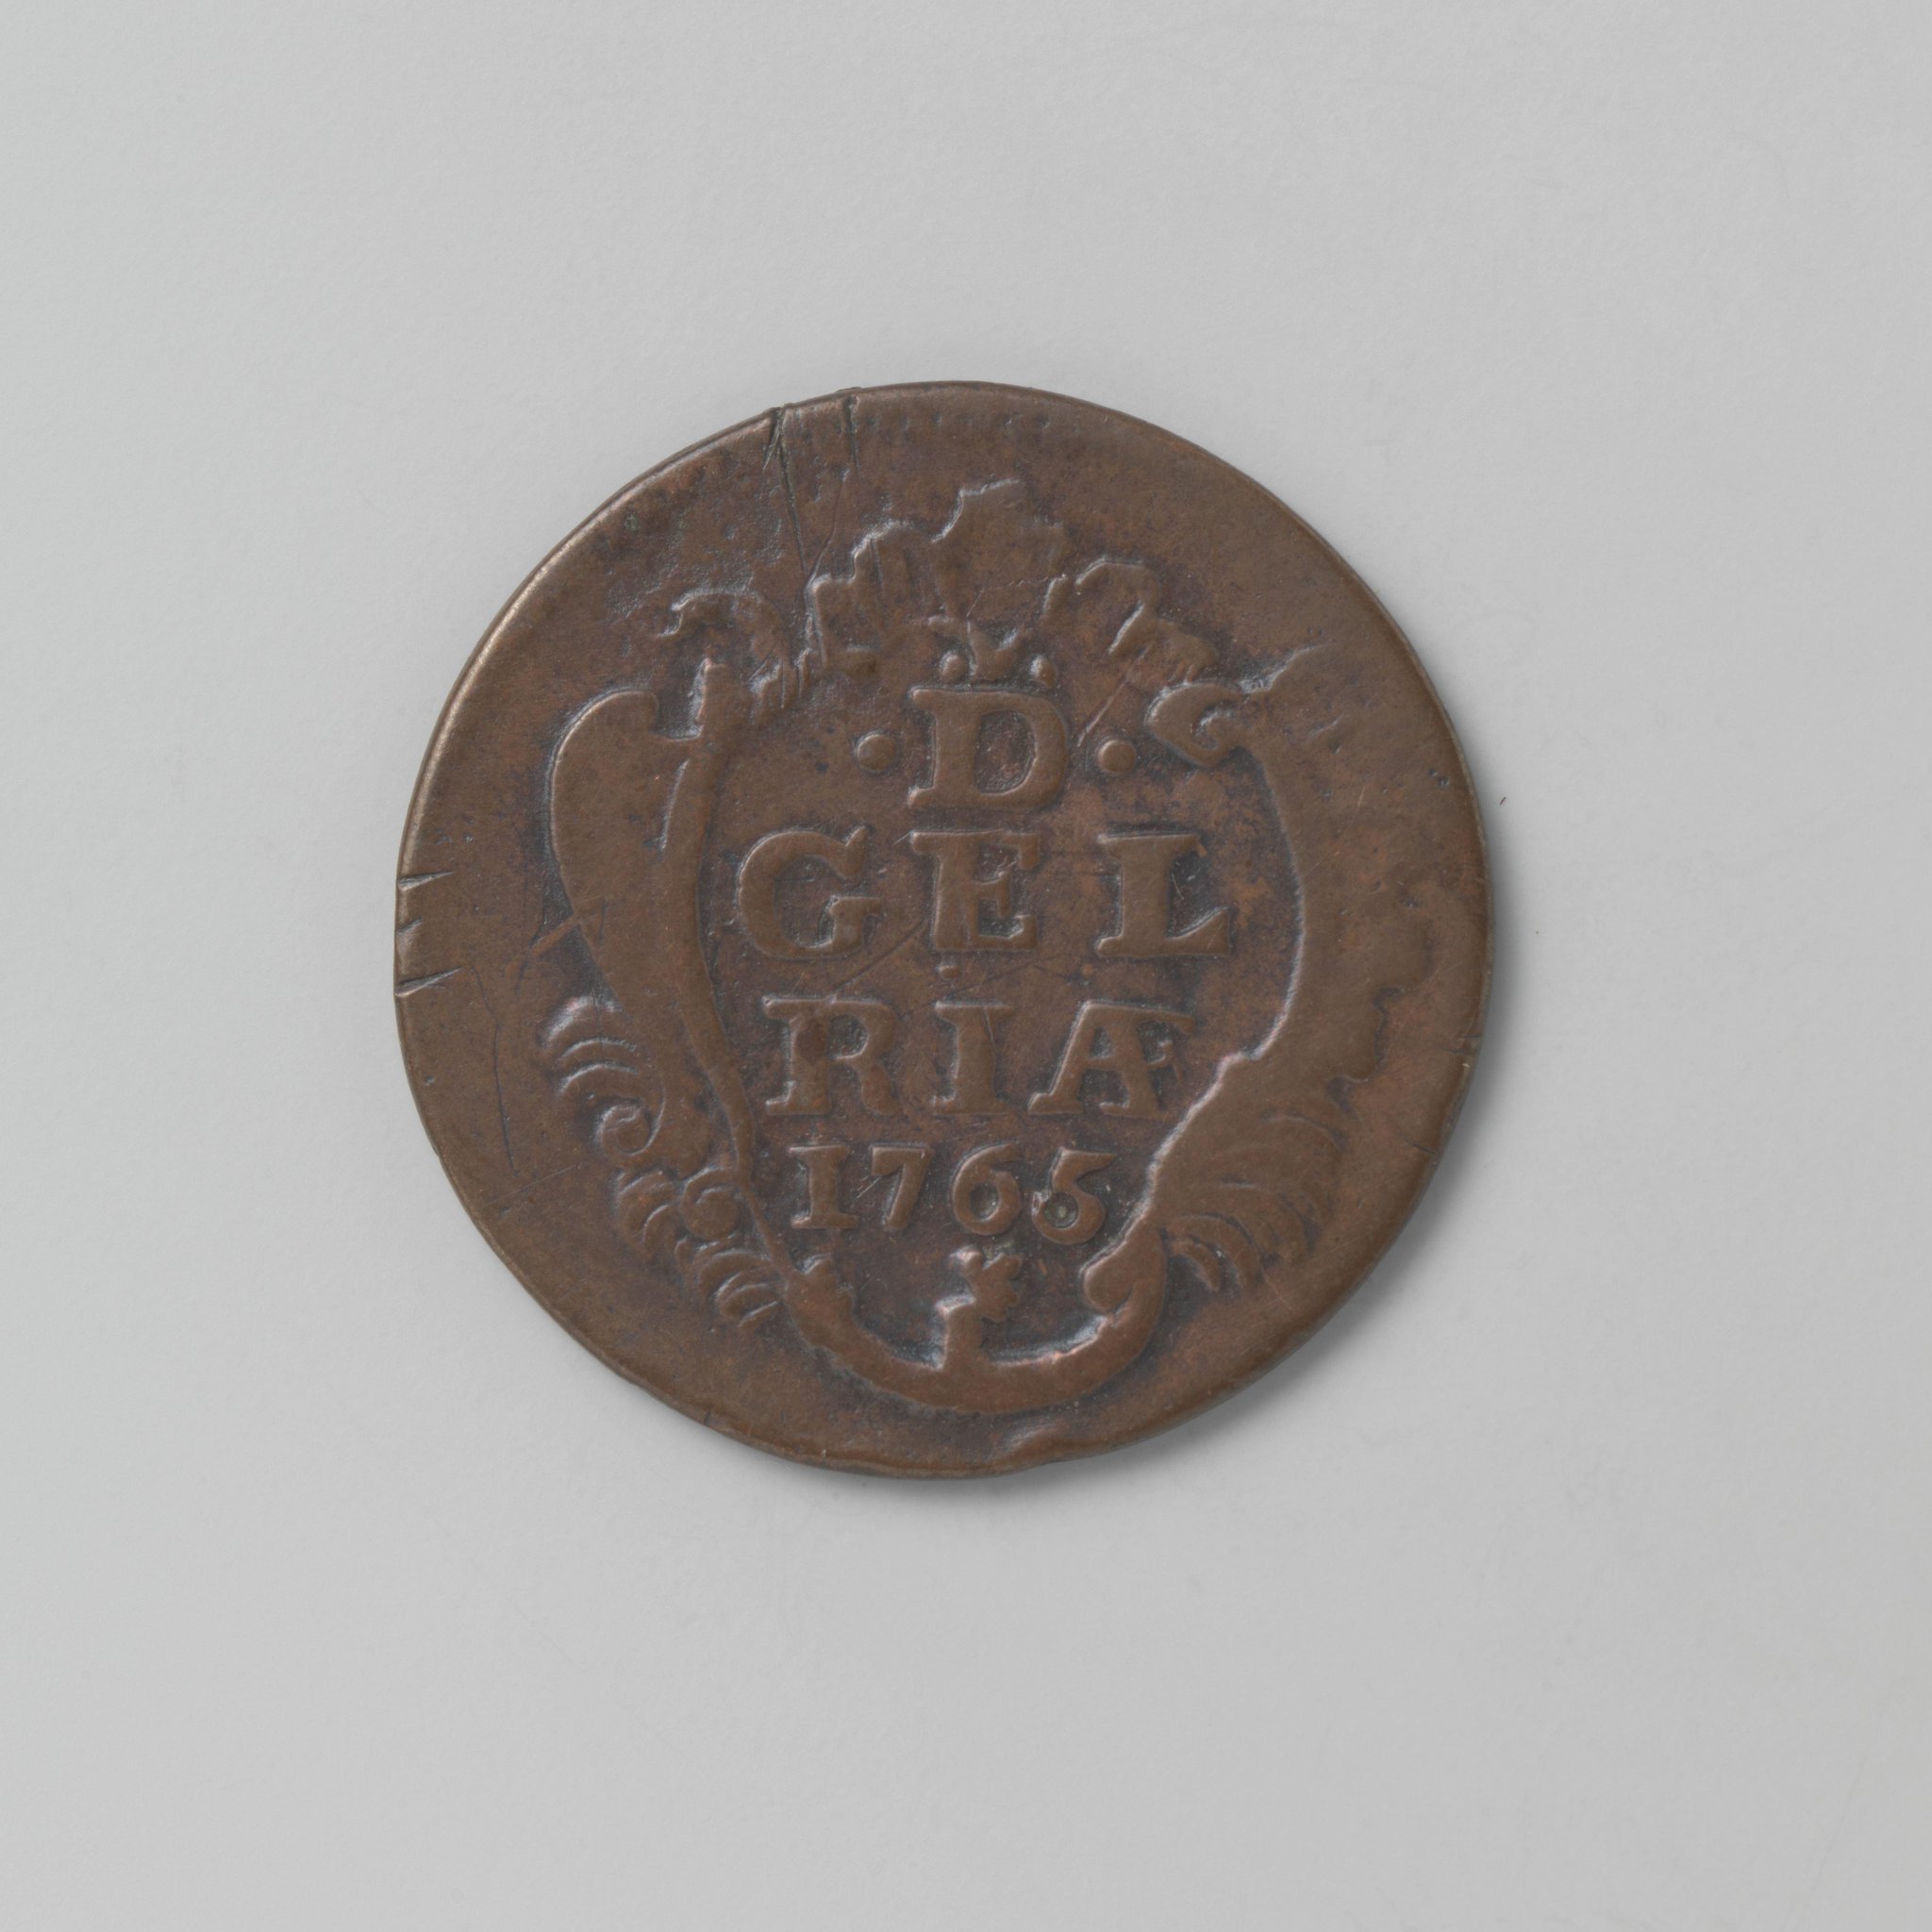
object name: duit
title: Gelderland, duit, 1765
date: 1765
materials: copper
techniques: striking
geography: harderwijk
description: Koperen munt. Voorzijde: binnen weelderige rococo-versiering in drie regels D/GEL/RIAE, daaronder jaartal en muntmeesterteken. Keerzijde: gekroond Gelders wapenschild.